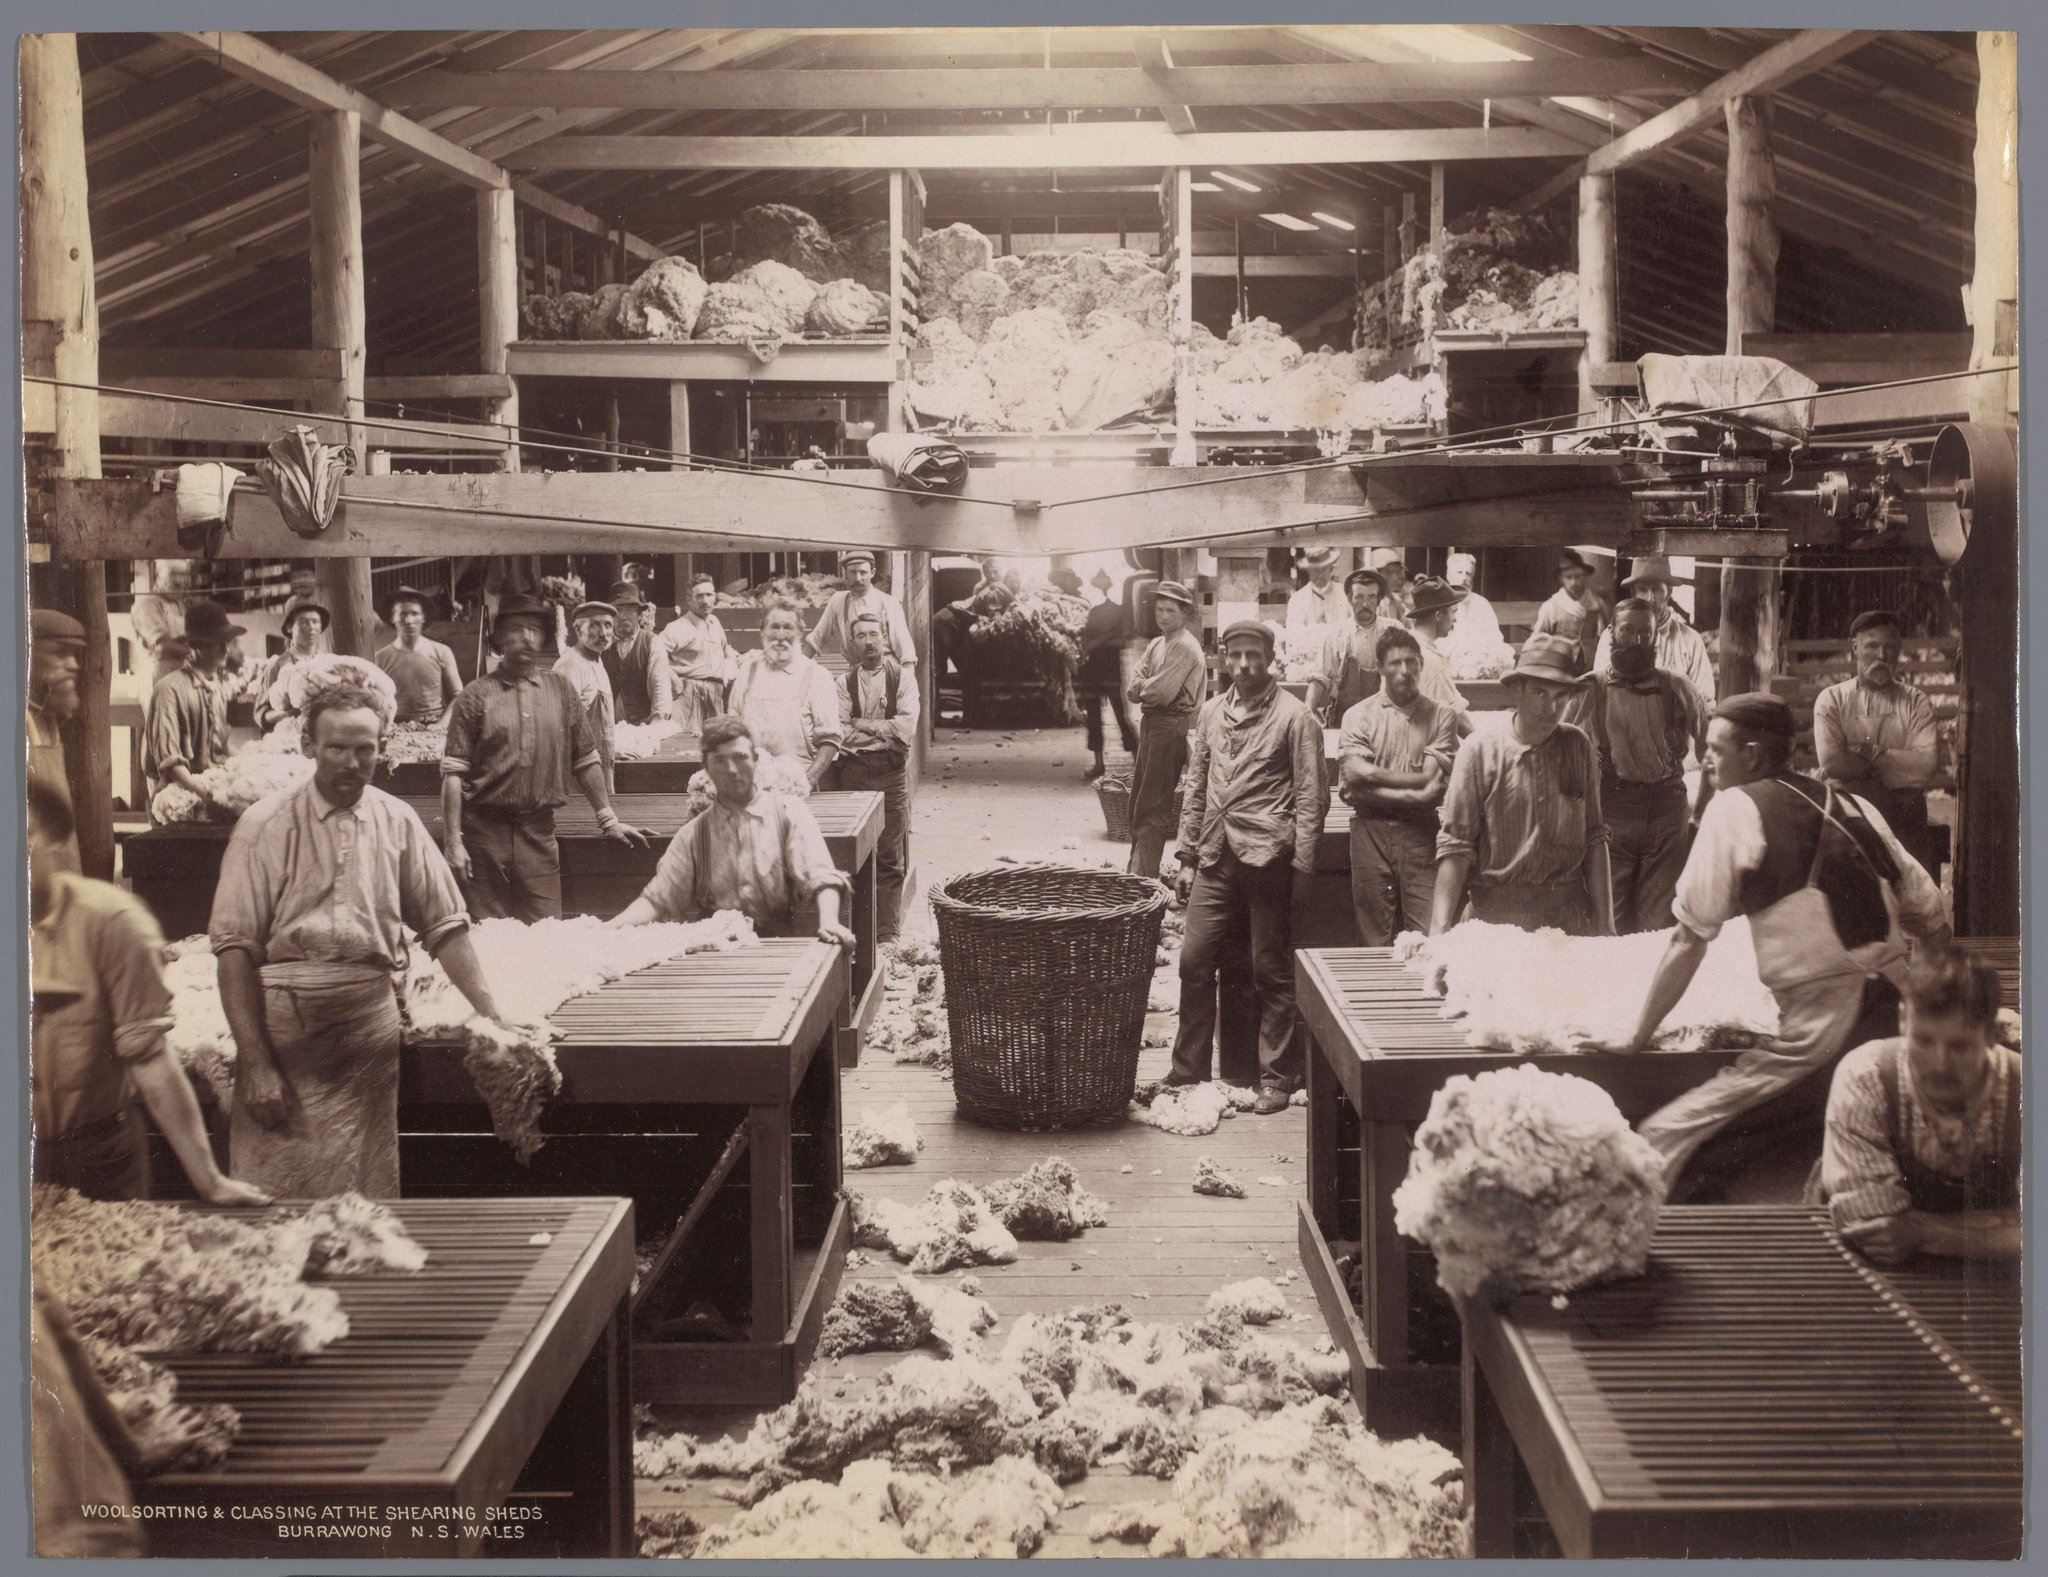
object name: photograph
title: Woolsorting and Classing at the Shearing Sheds Burrawong N.S. Wales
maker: charles henry kerry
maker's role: fotograaf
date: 1890-1900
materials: paper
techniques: albumen print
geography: burrawang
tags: special processes for woollen fabric